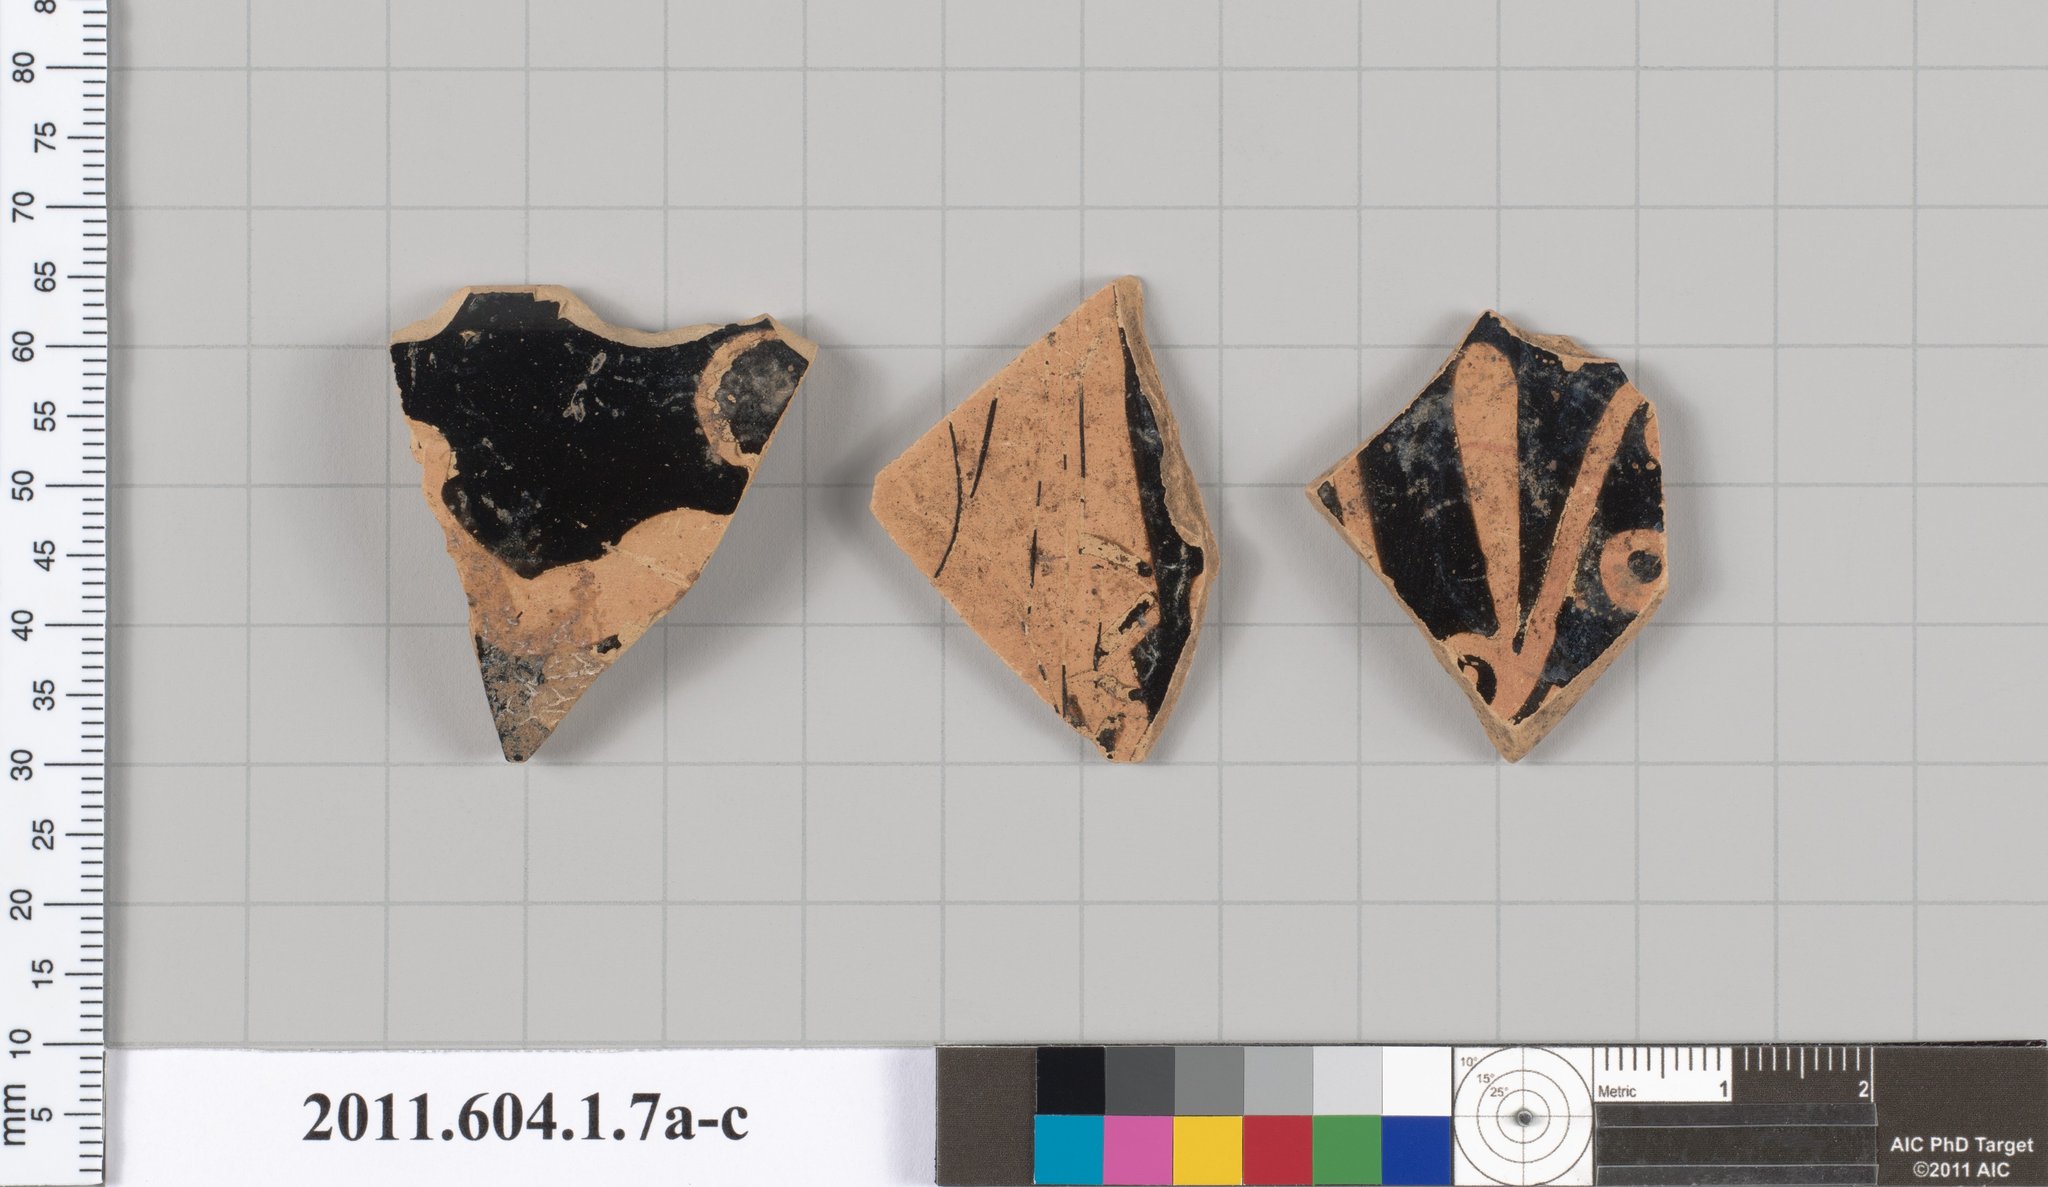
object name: kylix fragment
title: Terracotta fragments of a kylix (drinking cup)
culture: greek, attic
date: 467-435 BCE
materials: terracotta